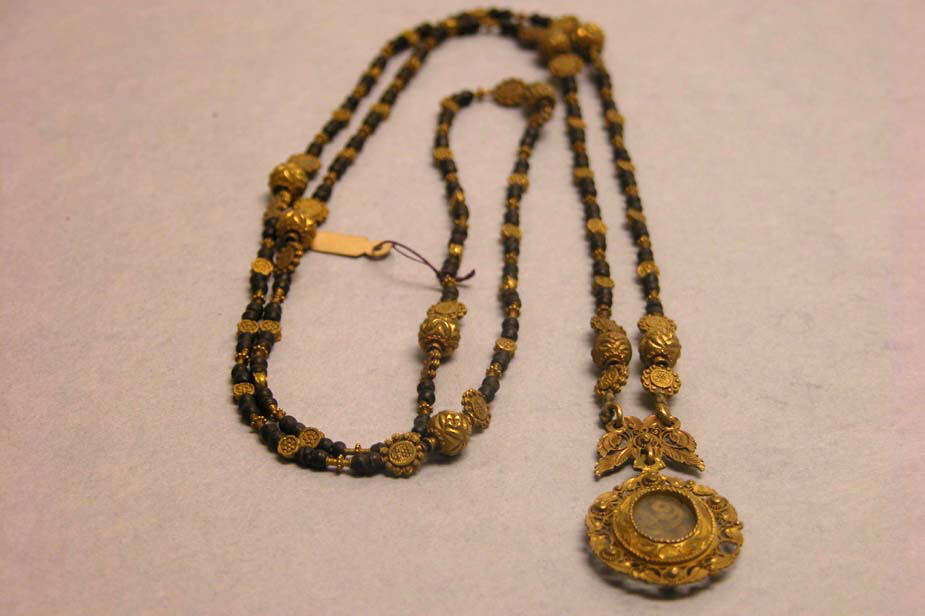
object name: rosary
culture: filipino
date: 1601-1900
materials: glass, gold